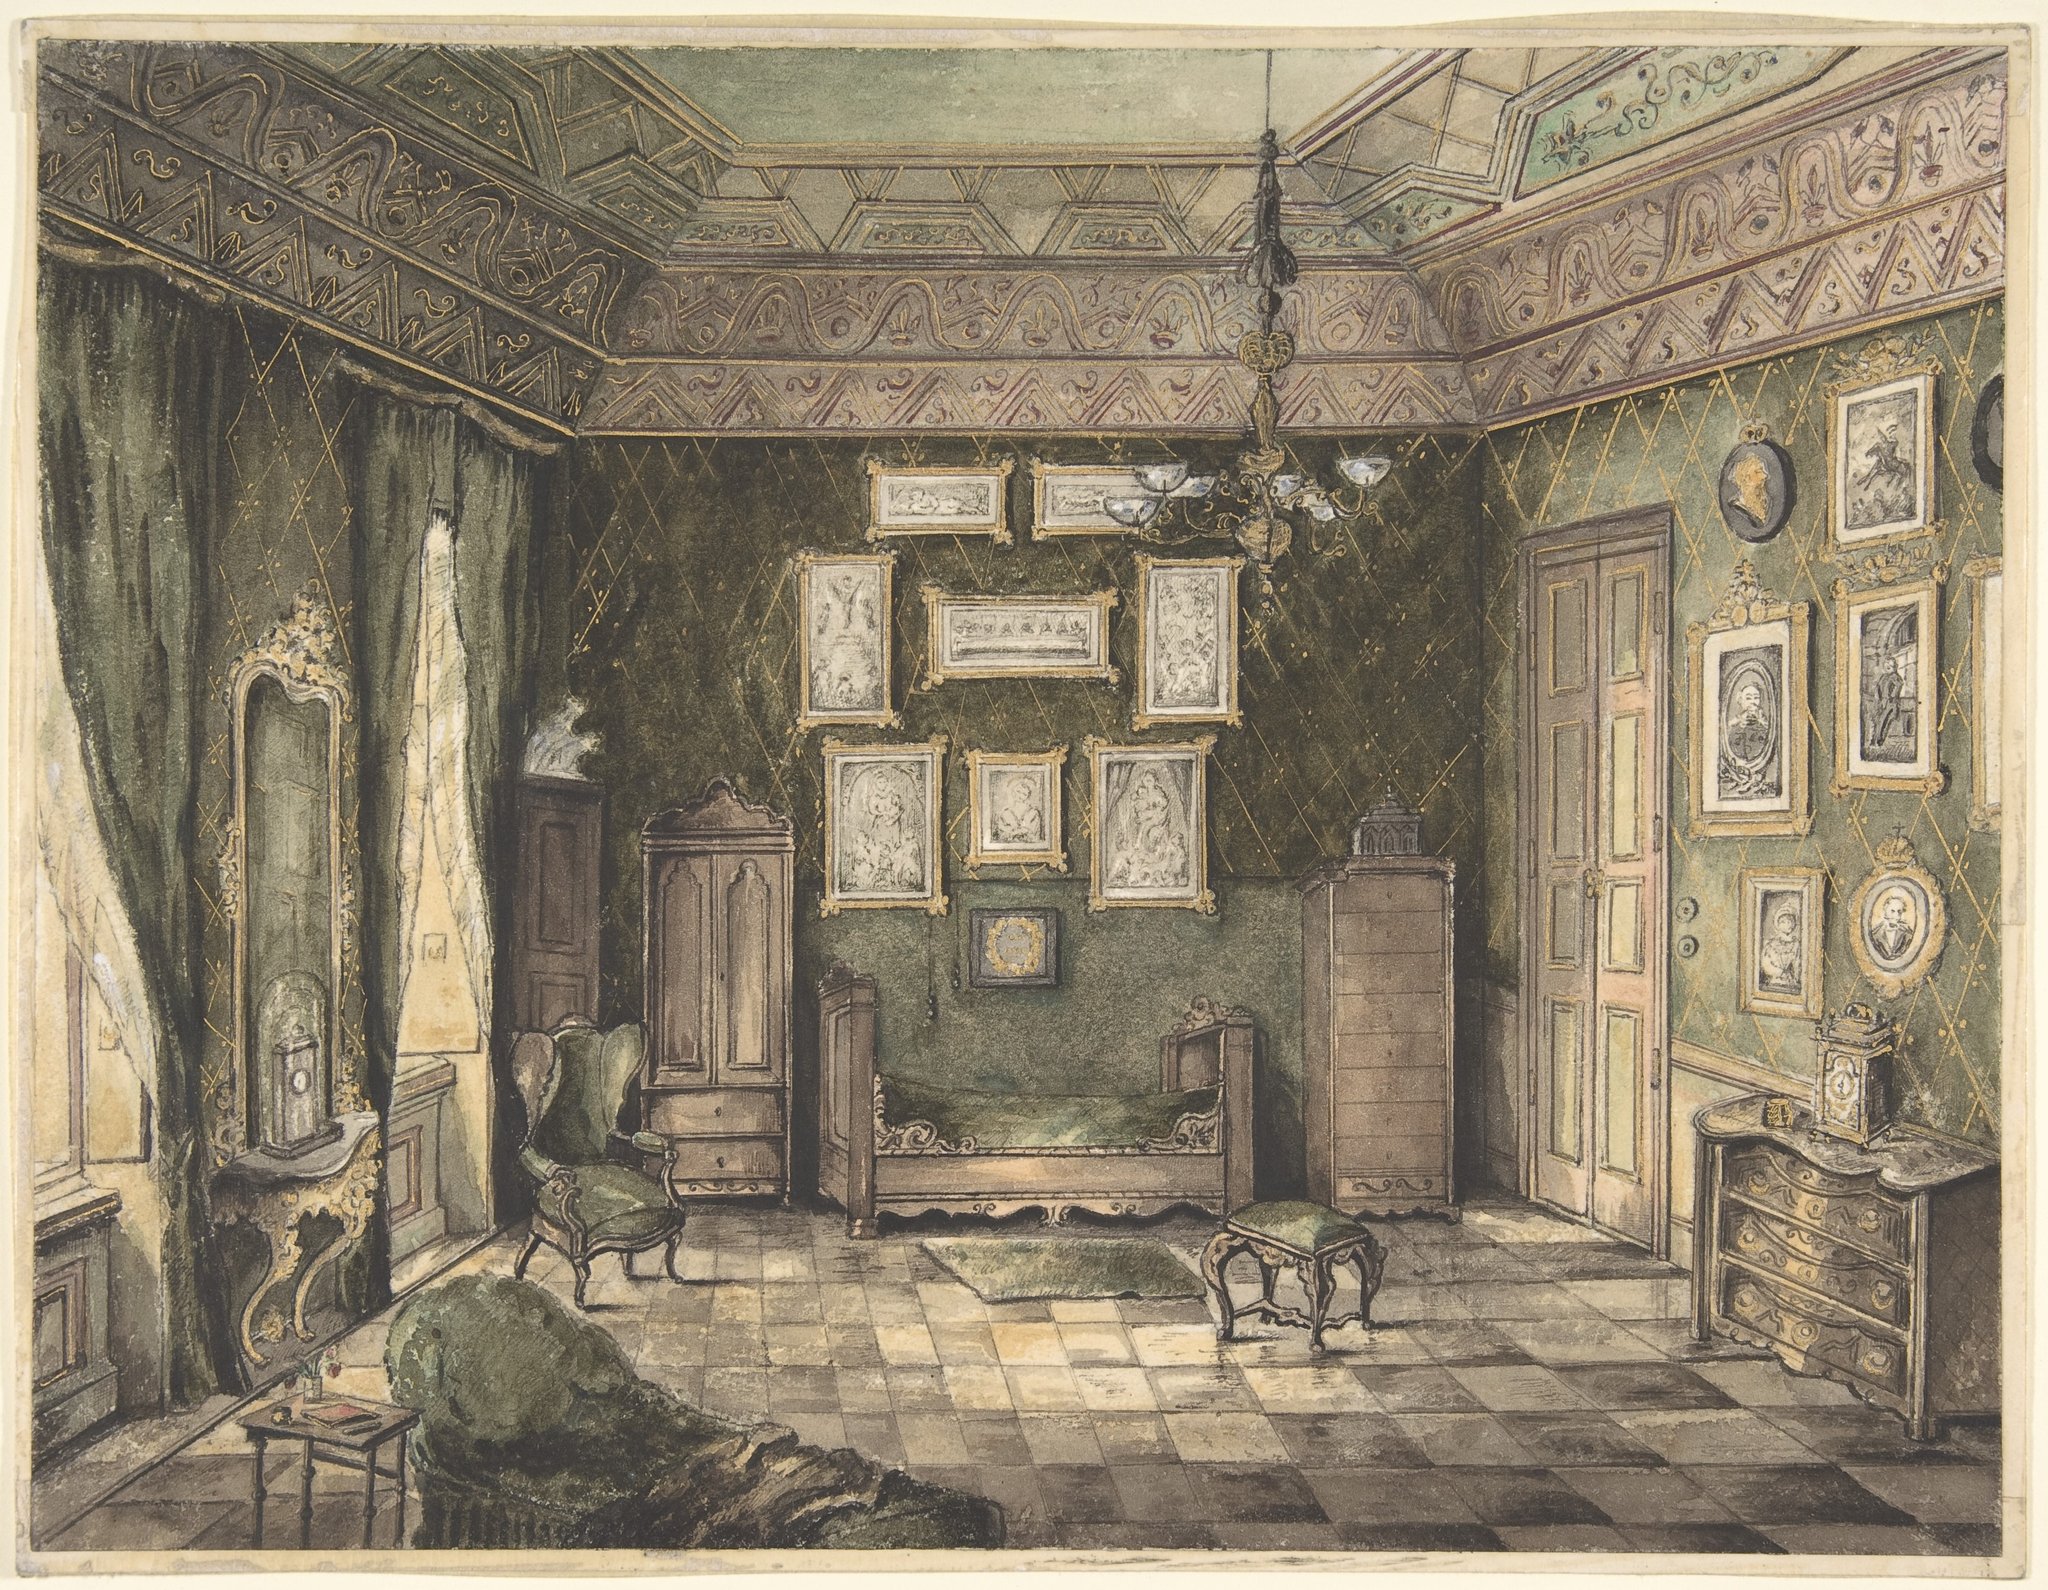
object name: drawing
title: Design for Interior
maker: anonymous, german, 19th century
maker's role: artist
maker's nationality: german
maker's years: 1800-1899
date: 1801-1900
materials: graphite, ink, watercolor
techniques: pen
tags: doors,interiors,chairs,stools,cabinets